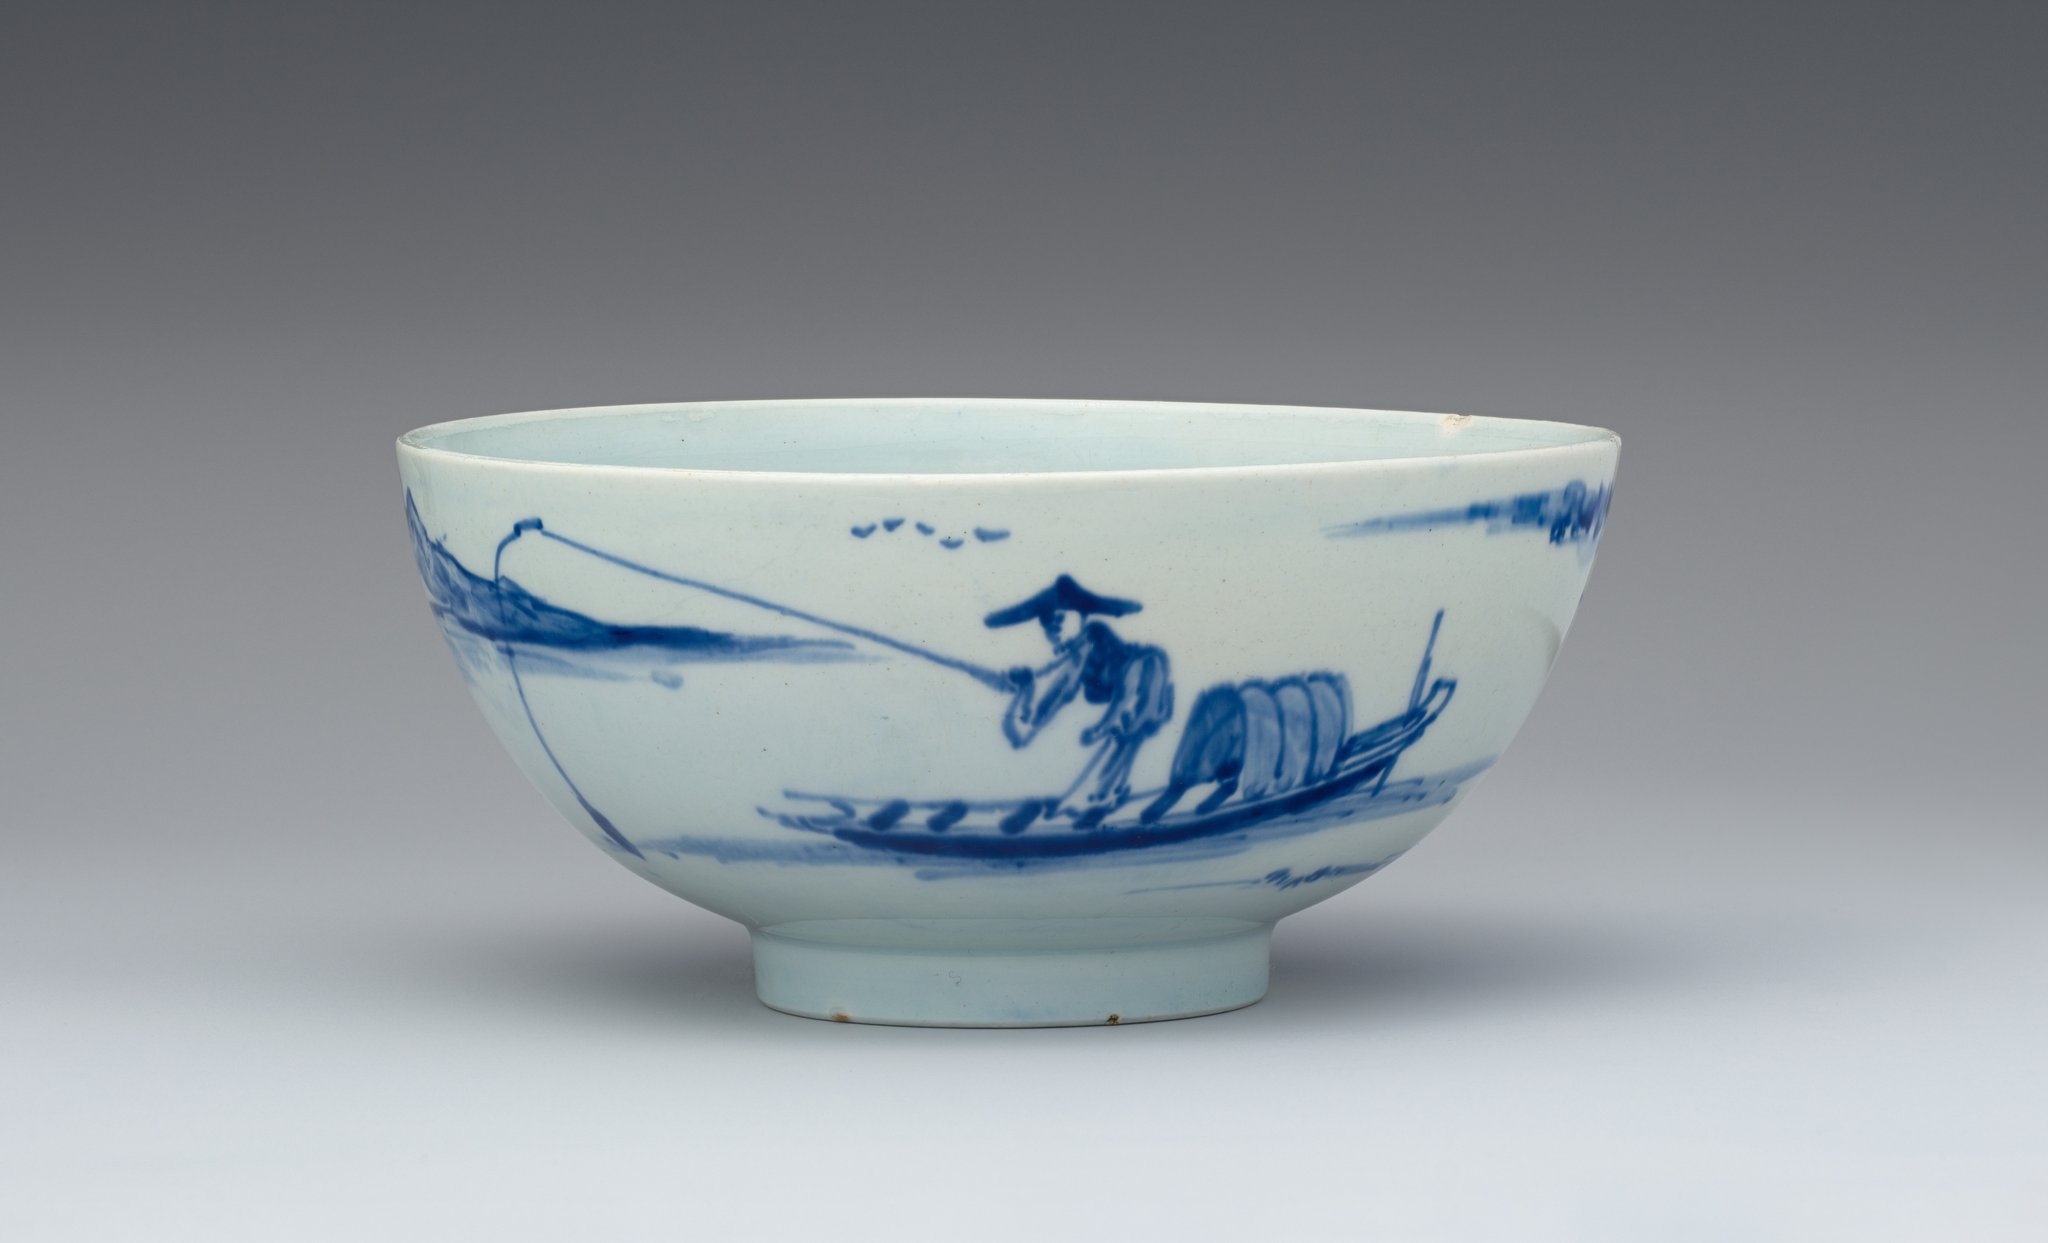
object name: bowl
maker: vauxhall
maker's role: factory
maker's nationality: british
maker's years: 1748-1768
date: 1753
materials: soft paste porcelain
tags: birds,men,fishing,boats